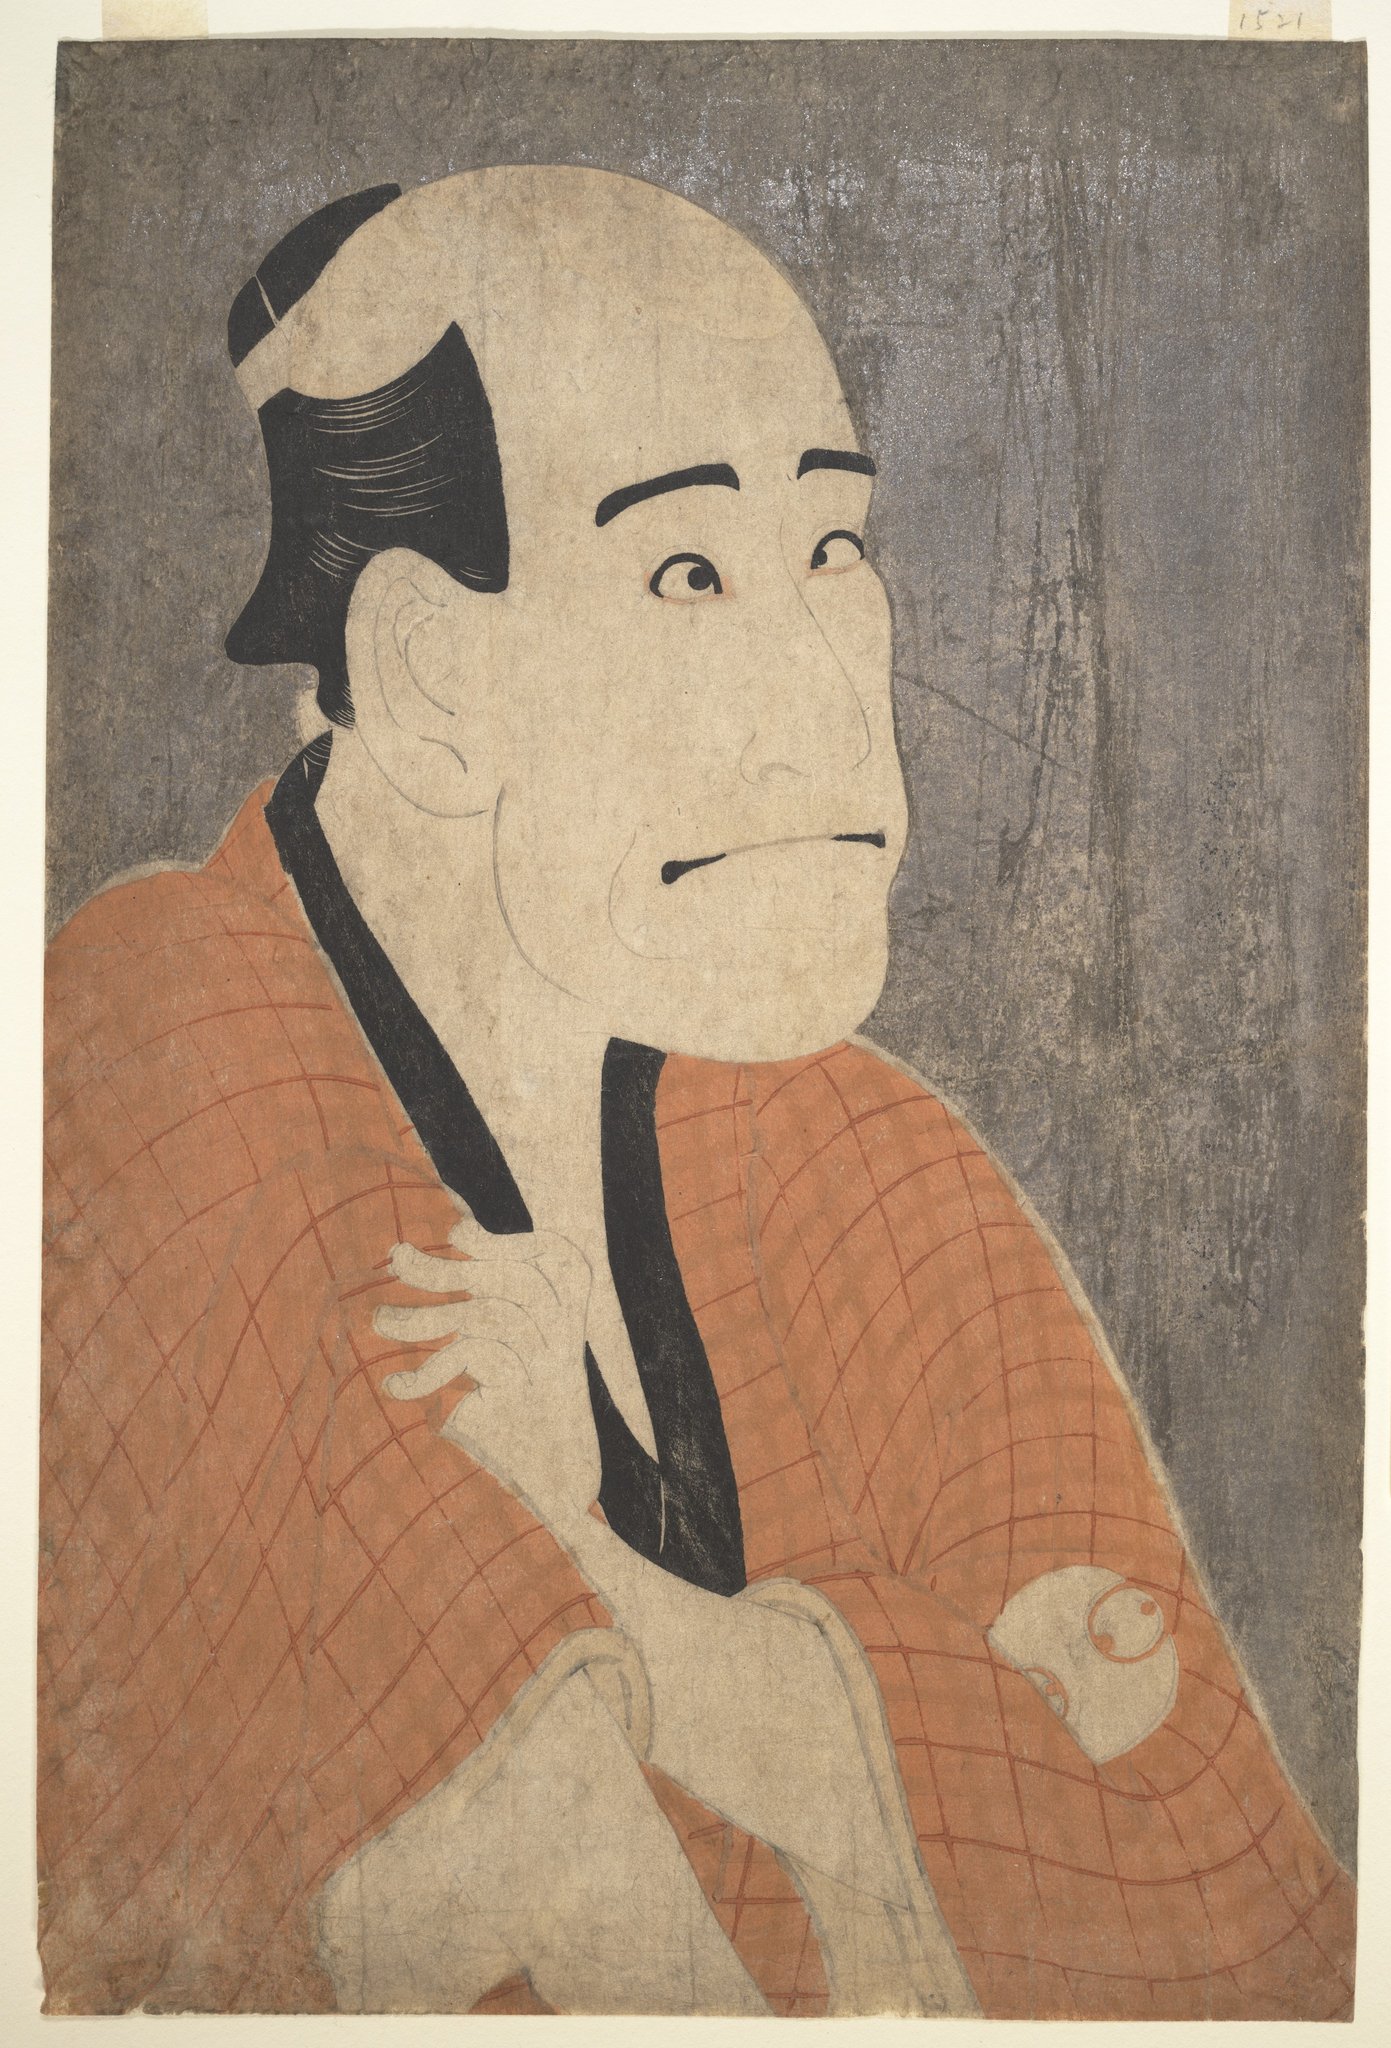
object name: print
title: Arashi Ryūzō I as Ishibe Kinkichi in the Play "Hana Ayame Bunroku Soga"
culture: japanese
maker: tōshūsai sharaku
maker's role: artist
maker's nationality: japanese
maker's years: 1794-1795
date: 1794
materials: ink, mica, paper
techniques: woodblock print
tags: men,actors